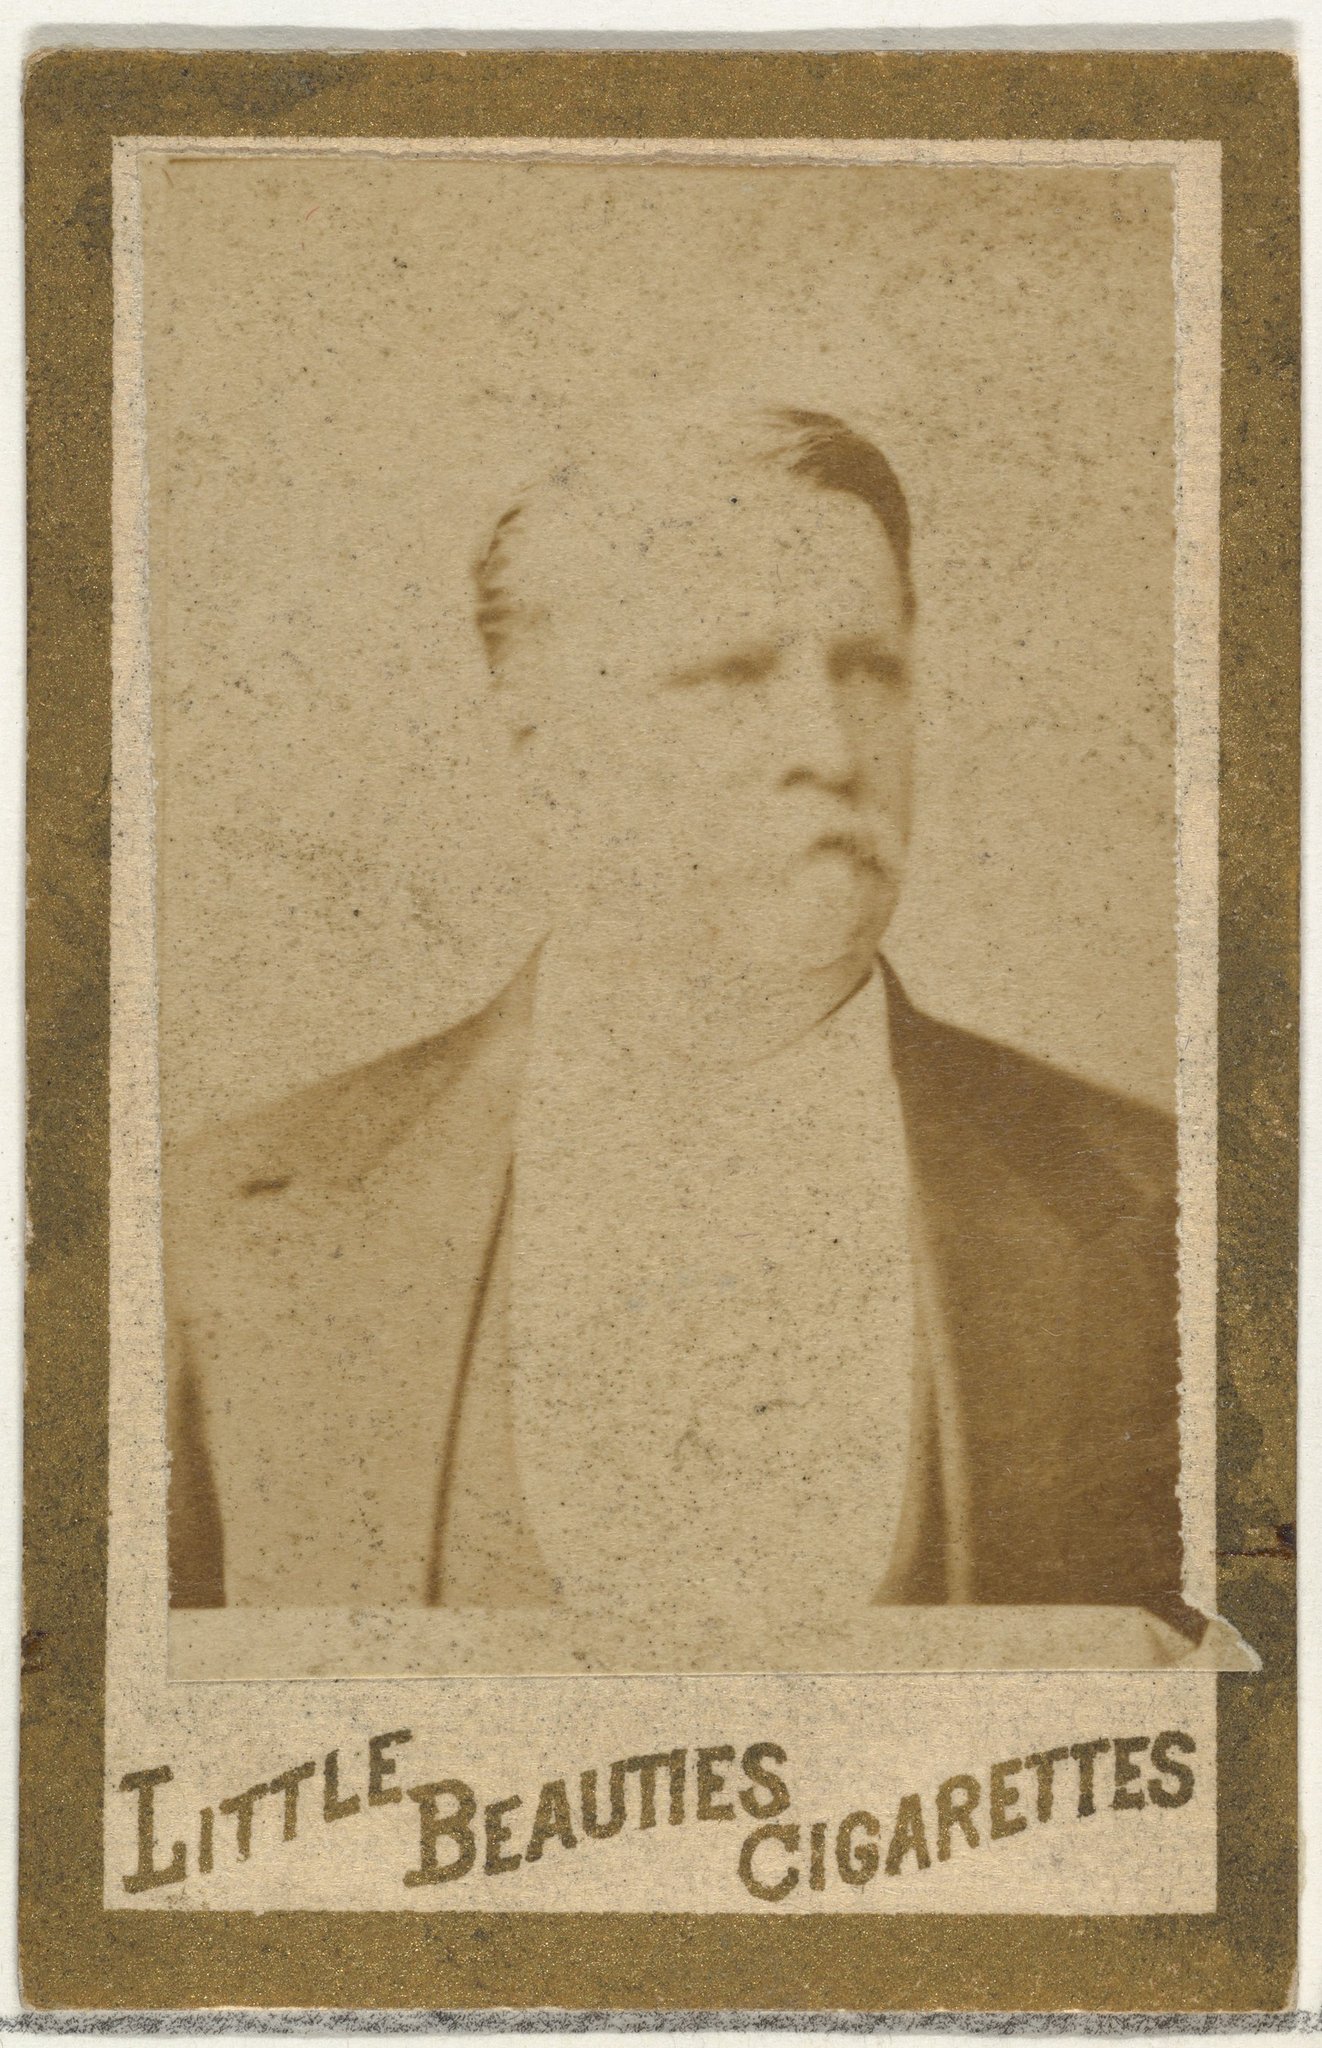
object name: photograph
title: From the Actresses and Celebrities series (N60, Type 1) promoting Little Beauties Cigarettes for Allen & Ginter brand tobacco products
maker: allen & ginter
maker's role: publisher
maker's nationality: american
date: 1887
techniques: albumen silver print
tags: men,portraits